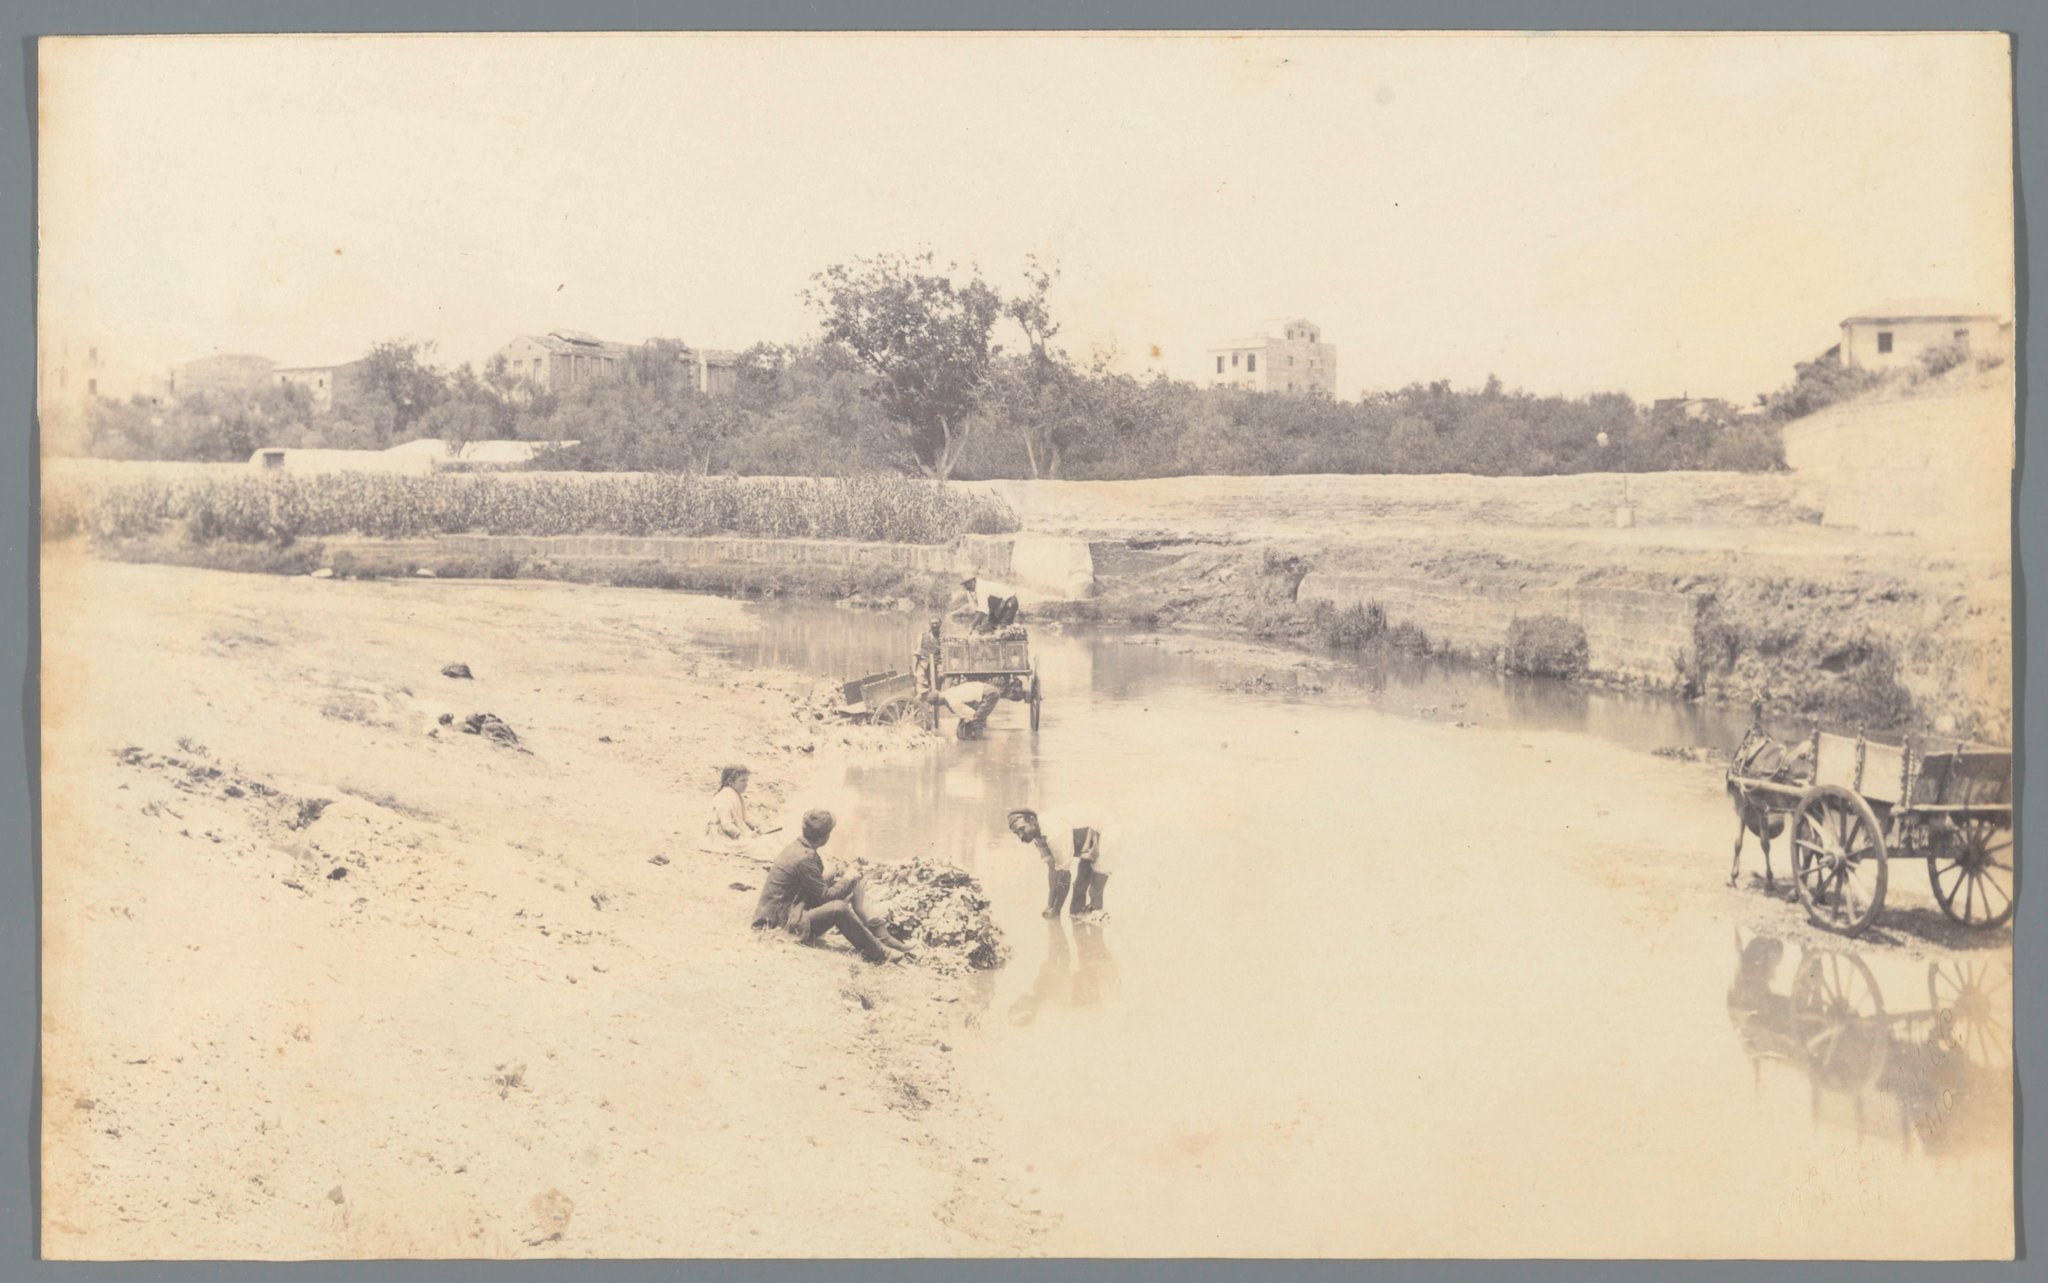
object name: photograph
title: Wassende mensen in een rivier op Sicilië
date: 1880-1890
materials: paper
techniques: albumen print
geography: sicily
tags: river, washing and bathing - aa - in the open air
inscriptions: inscription: ‘bis/ 21’, inscription: ‘Sicilie’, inscription: ‘(t) Interguglielmi’